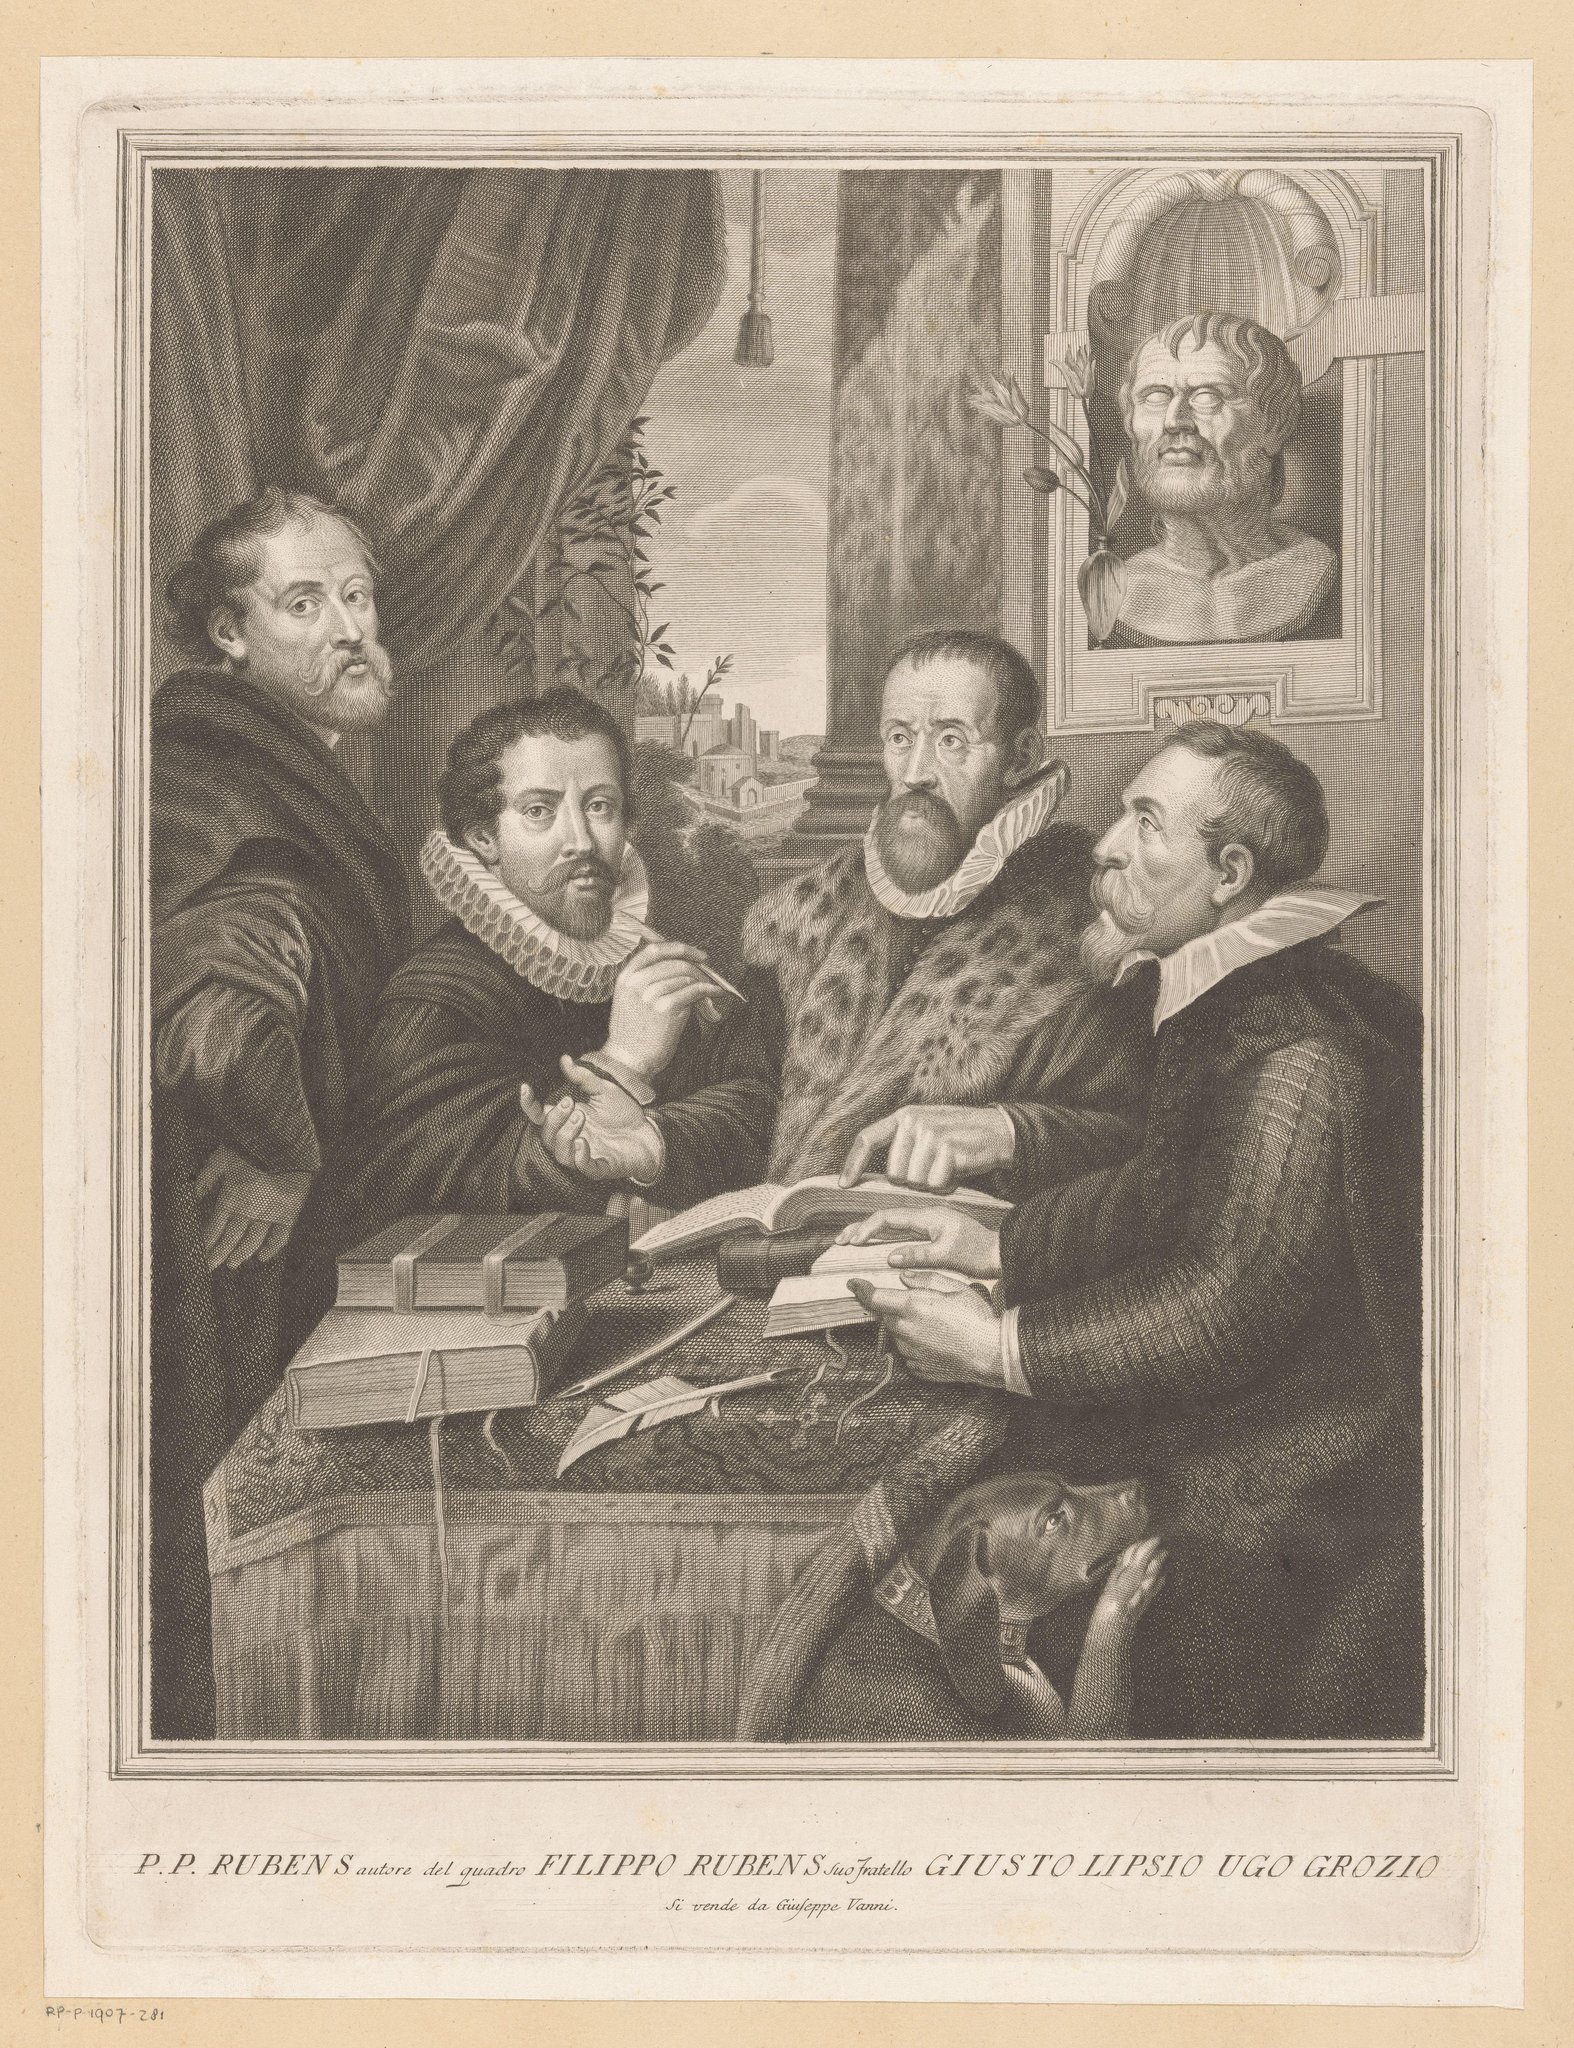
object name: print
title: Vier filosofen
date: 1770-1782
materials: paper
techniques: engraving, etching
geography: florence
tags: antwerp, brussels, jan van den wouwer, lucius annaeus seneca, painter, print maker, draughtsman, peter paul rubens, louvain, justus lipsius, scholar, philosopher, historical persons, portrait, self-portrait of artist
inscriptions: collector's mark: Lugt 2228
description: Groepsportret van vier mannen: Peter Paul Rubens, Philip Rubens, Justus Lipsius en Jan van den Wouwer (op de prent als Hugo de Groot), rond een tafel. Rechts een buste van de filosoof Seneca.